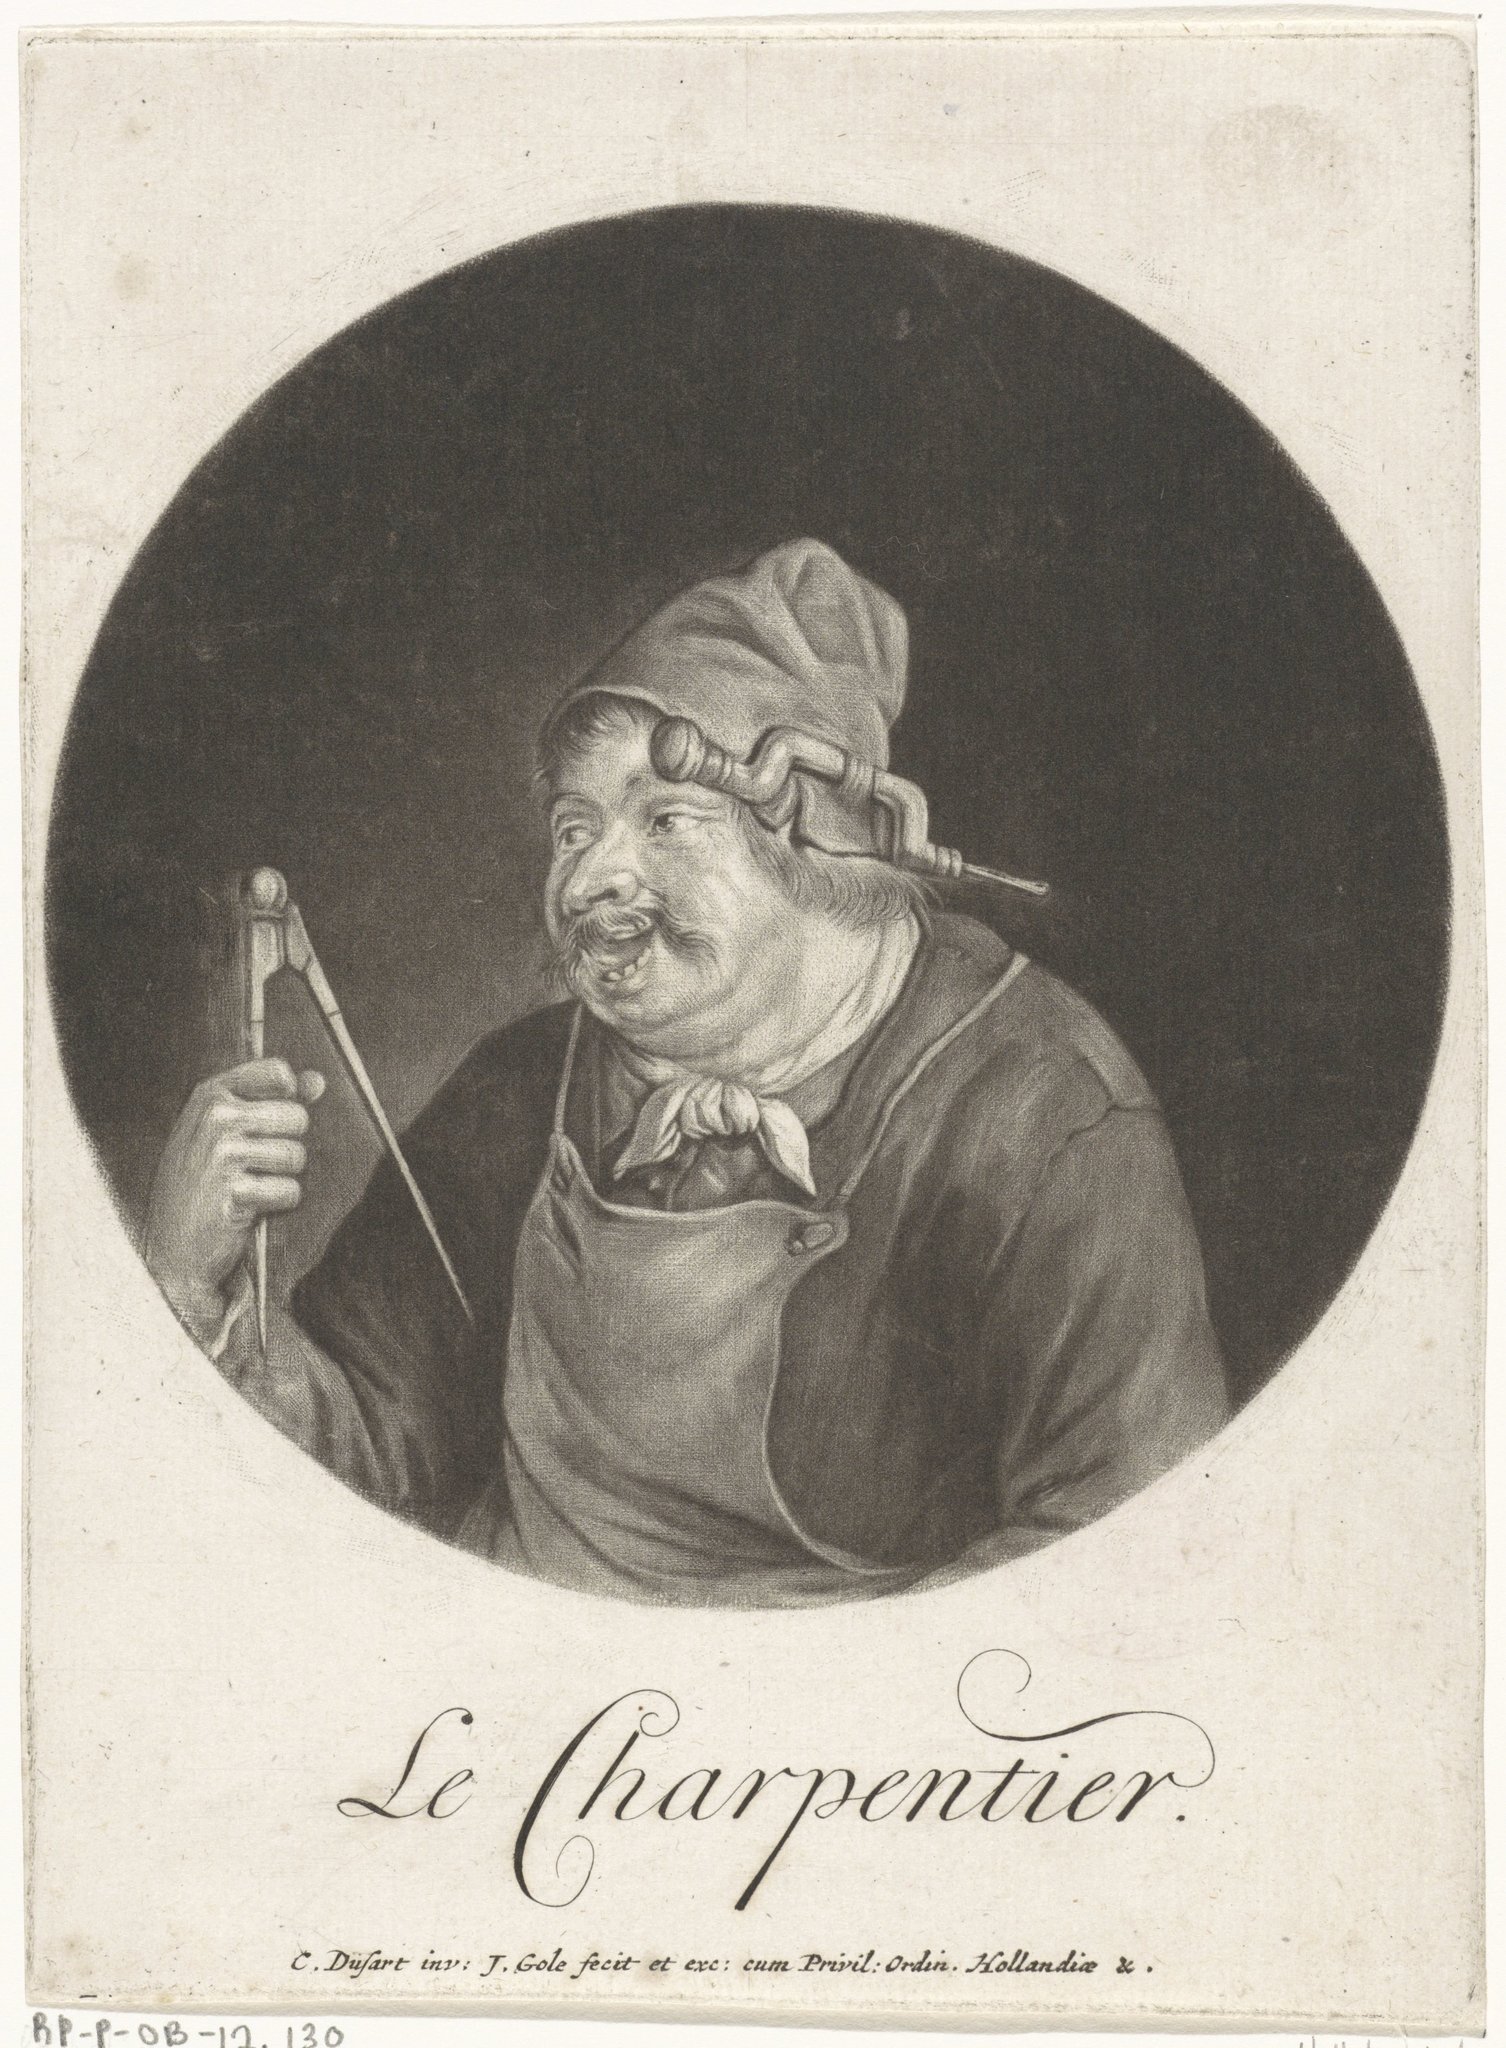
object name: print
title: Le Charpentier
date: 1670-1724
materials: paper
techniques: engraving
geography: amsterdam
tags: carpenter, compasses, tools, aids, implements ~ crafts and industries: drill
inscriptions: collector's mark: Lugt 240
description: Deze prent is de pendant van "Le Chirurgien" (Hollstein nr. 269a) van dezelfde prentmaker.